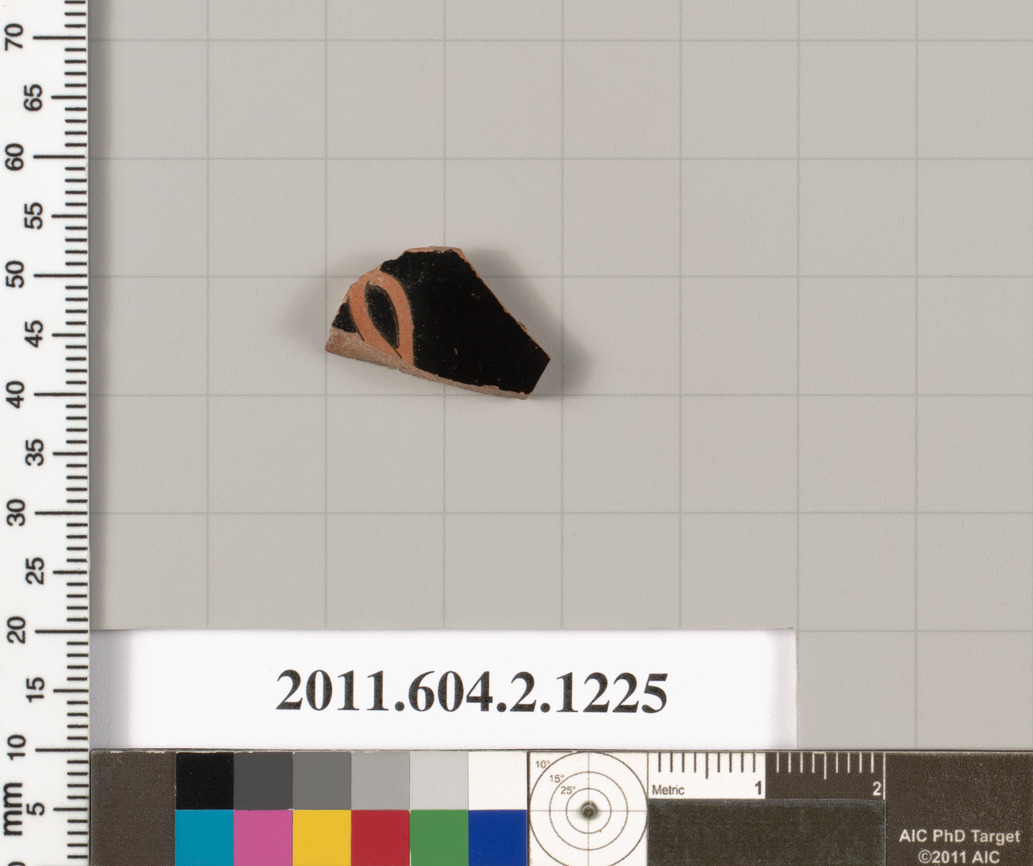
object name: kantharos fragment, head vase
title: Terracotta fragment from a kantharos: head vase?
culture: greek, attic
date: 500-476 BCE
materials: terracotta